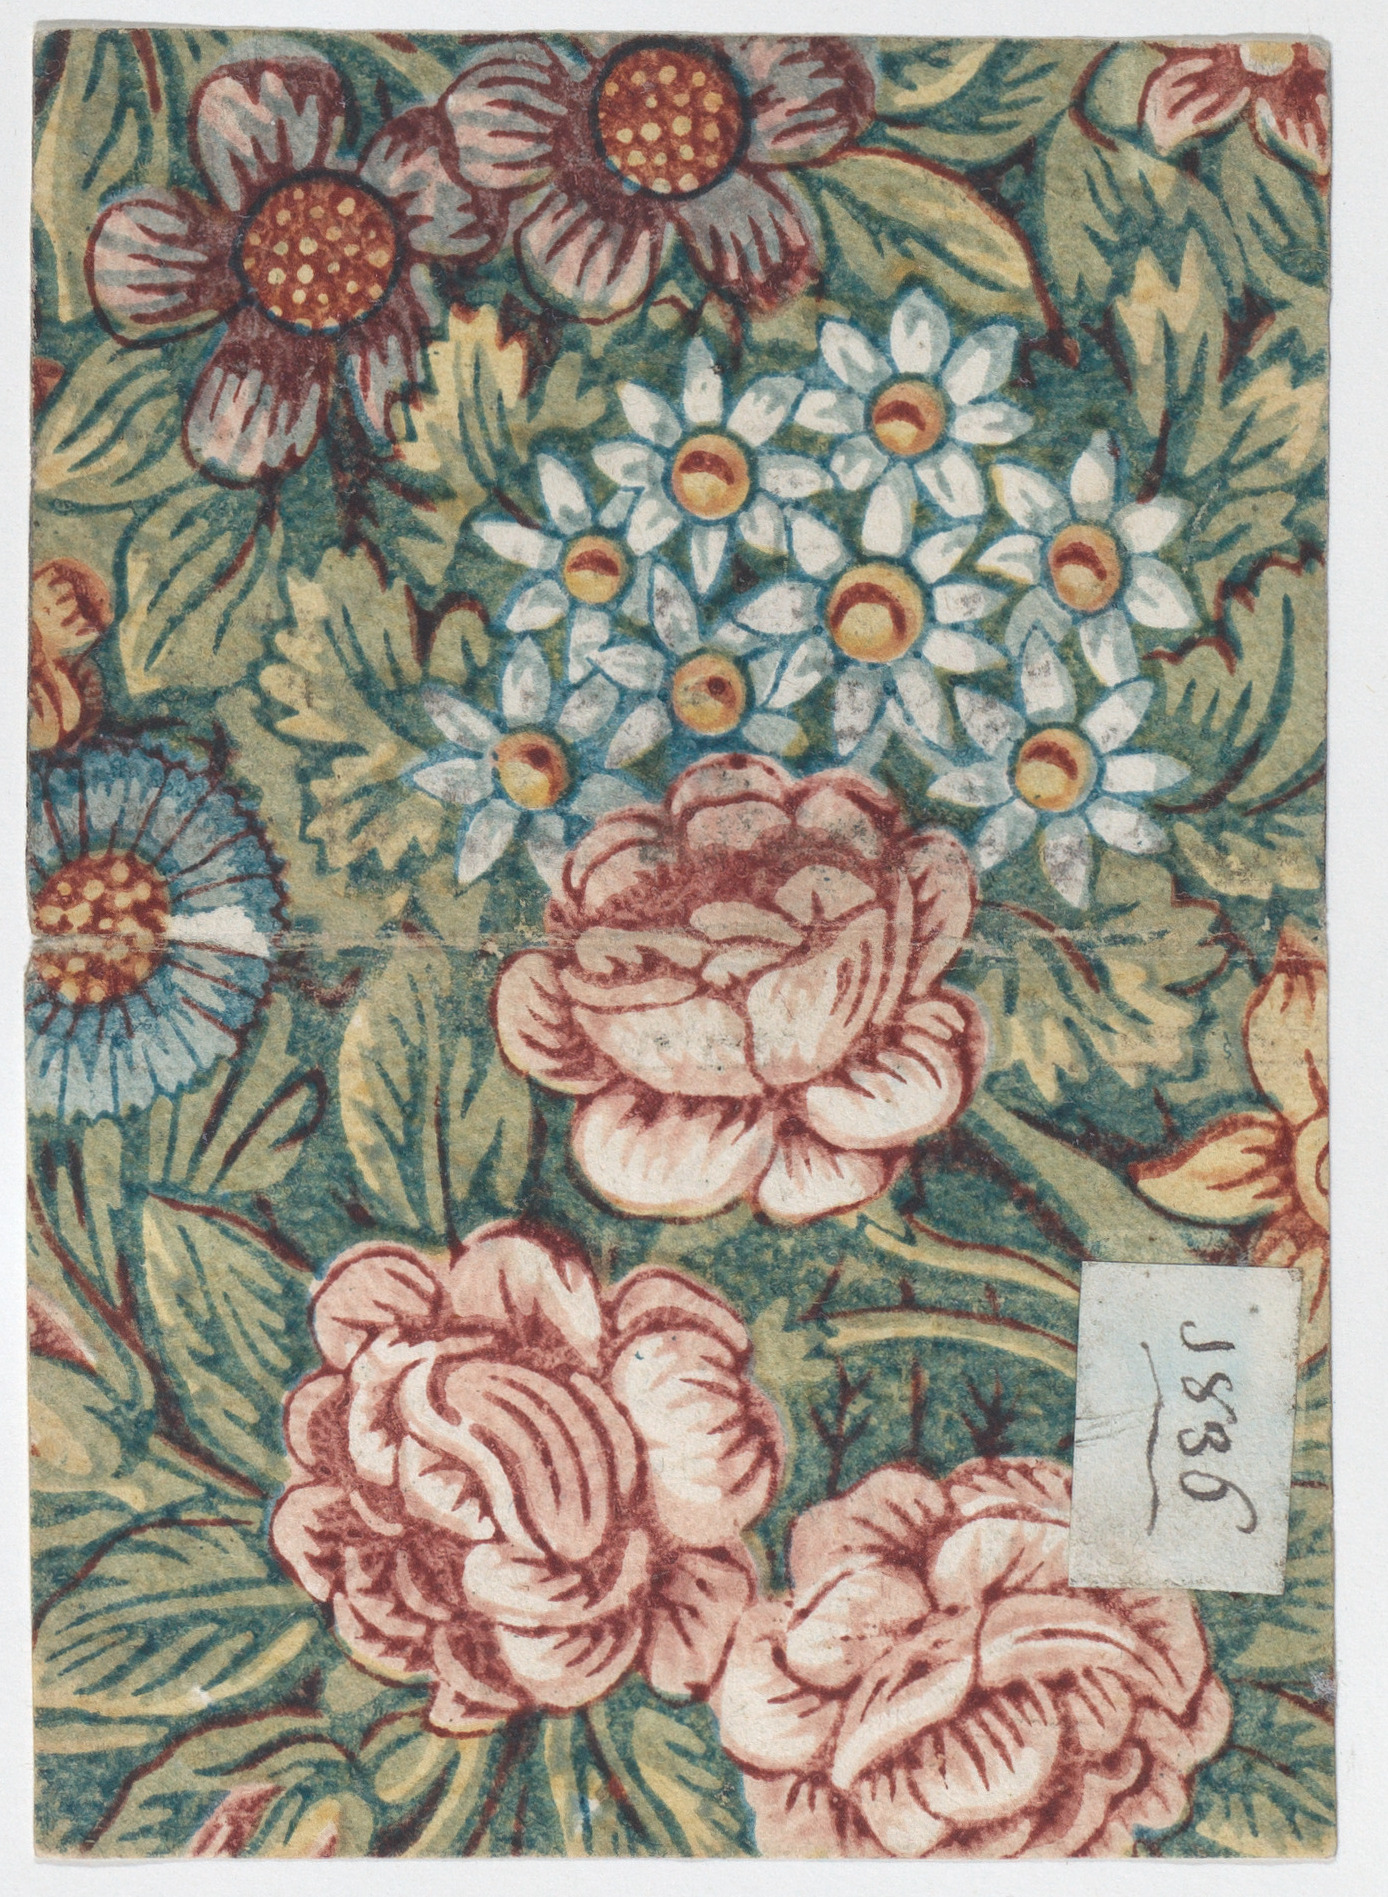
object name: print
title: Sheet with an overall floral pattern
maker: Anonymous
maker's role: artist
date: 1836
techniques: relief print